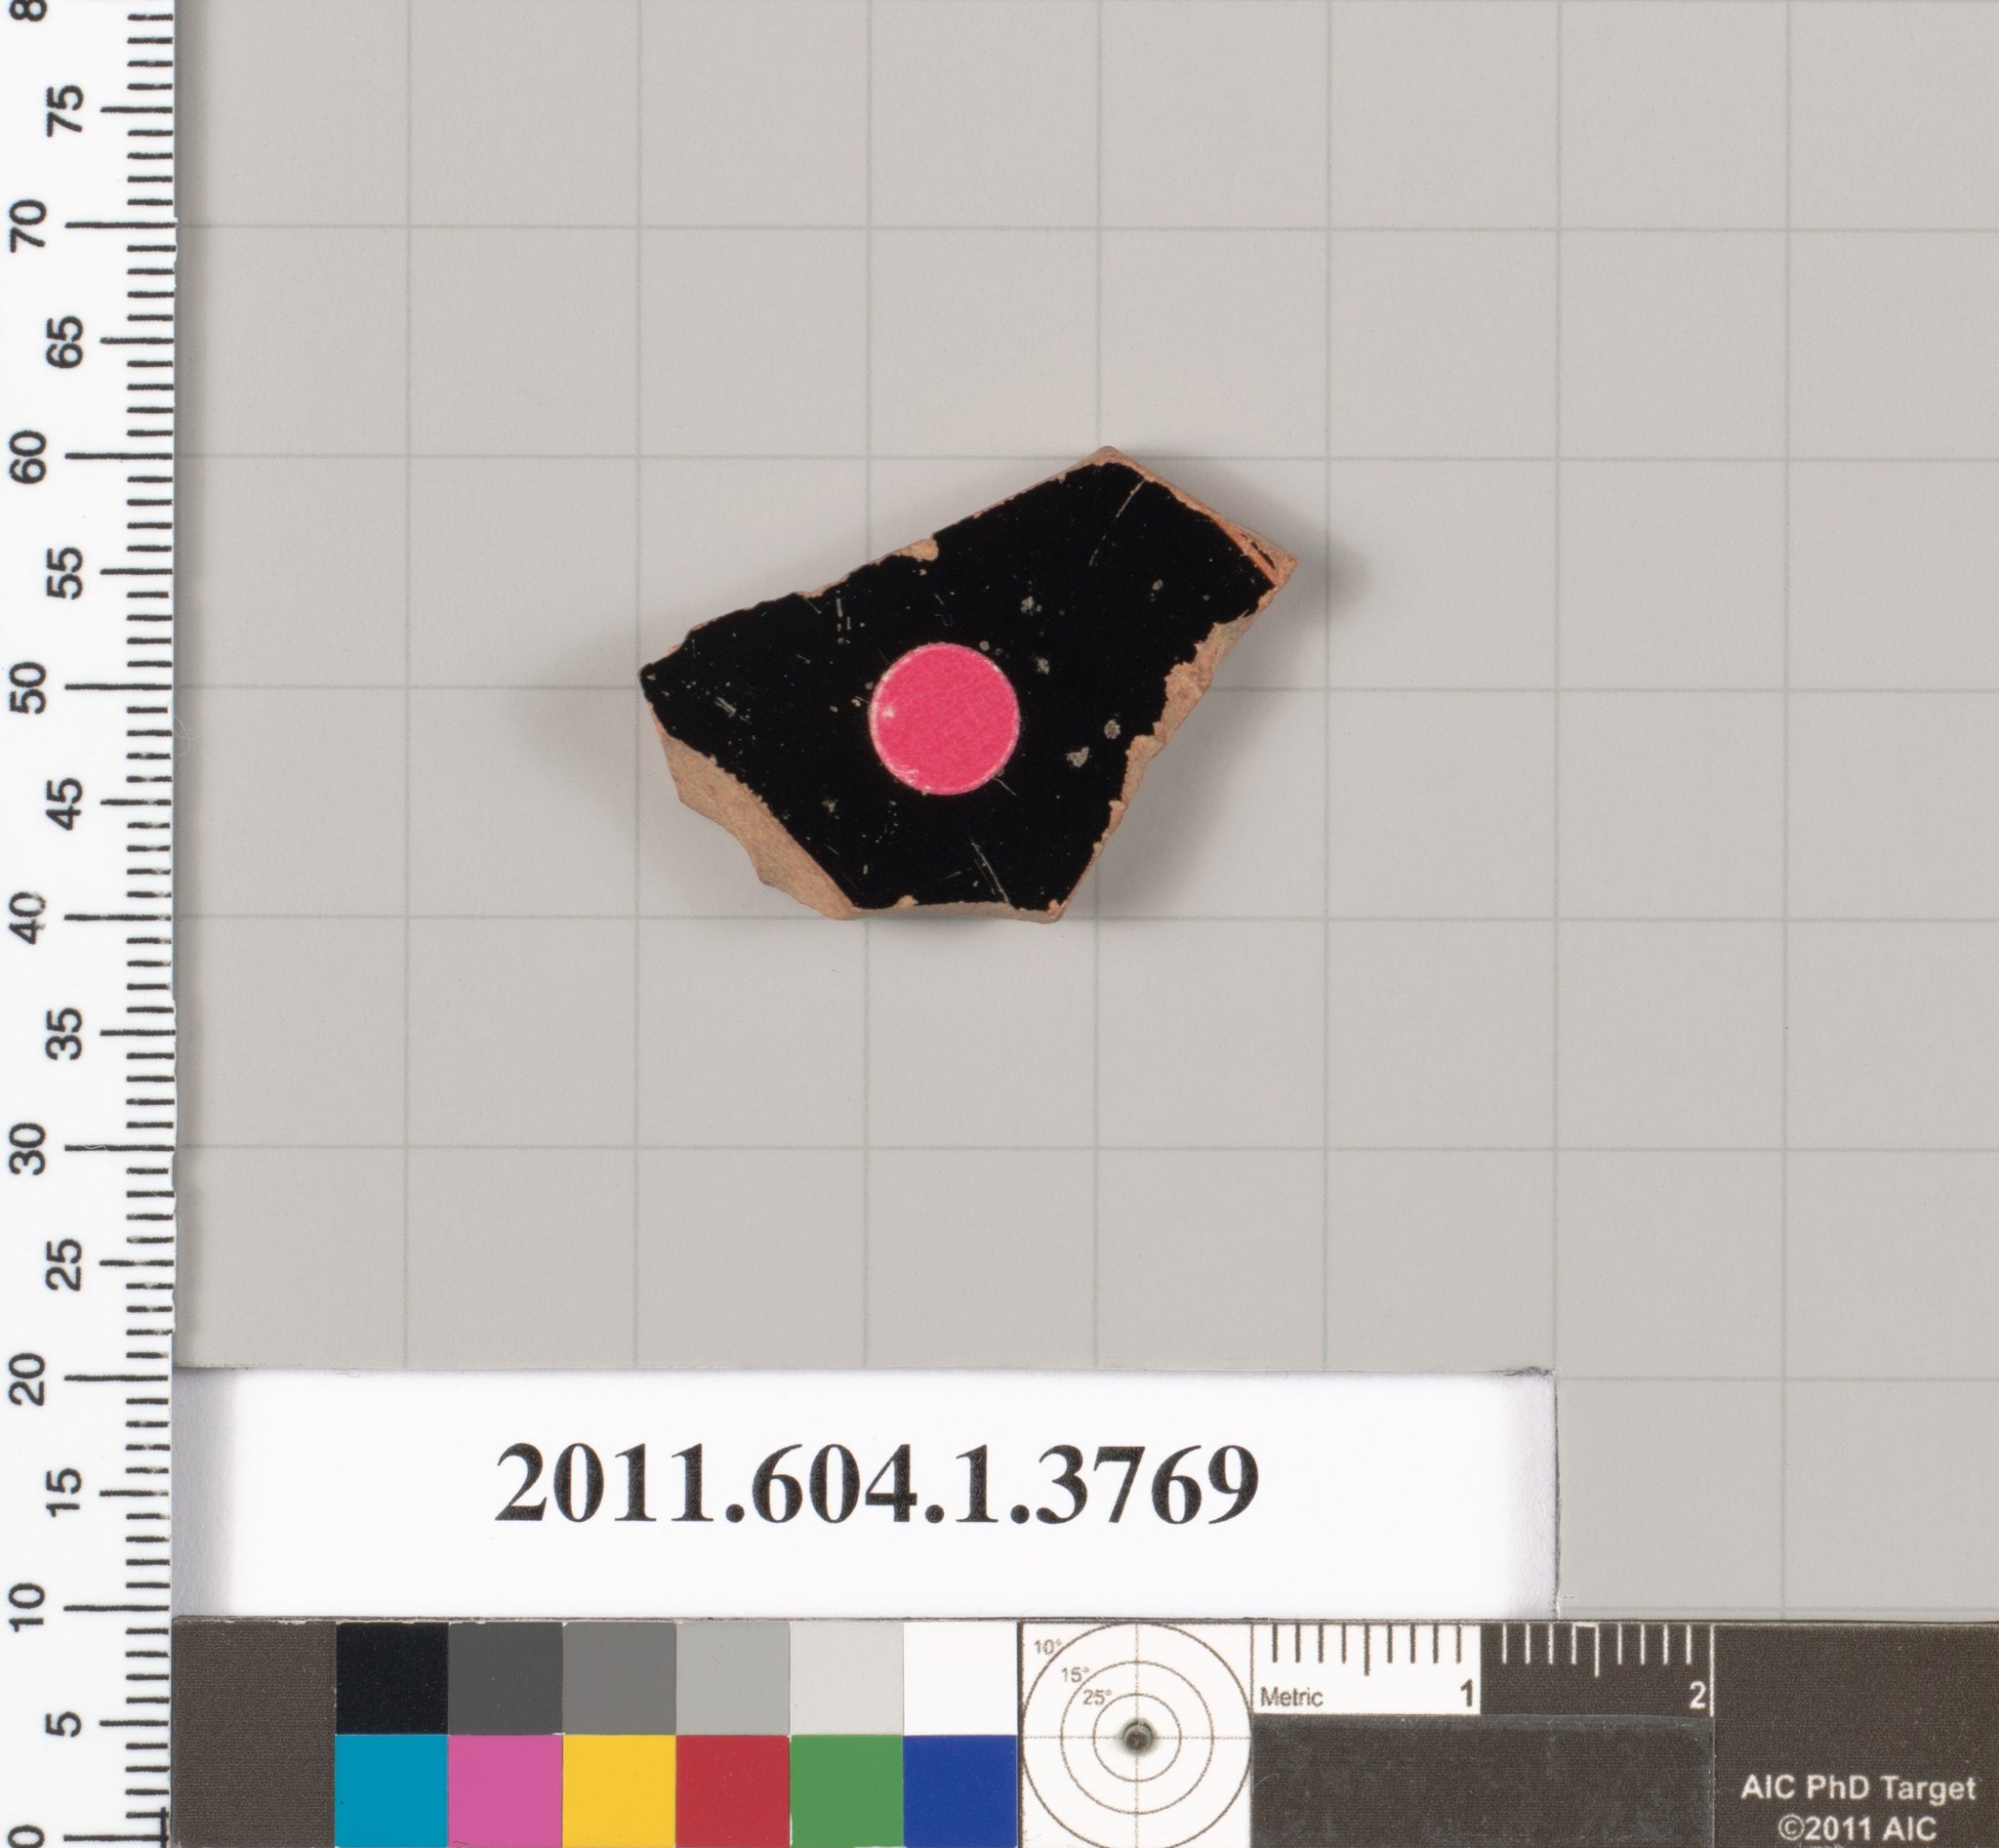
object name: kylix fragment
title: Terracotta fragment of a kylix (drinking cup)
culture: greek, attic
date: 401-450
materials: terracotta